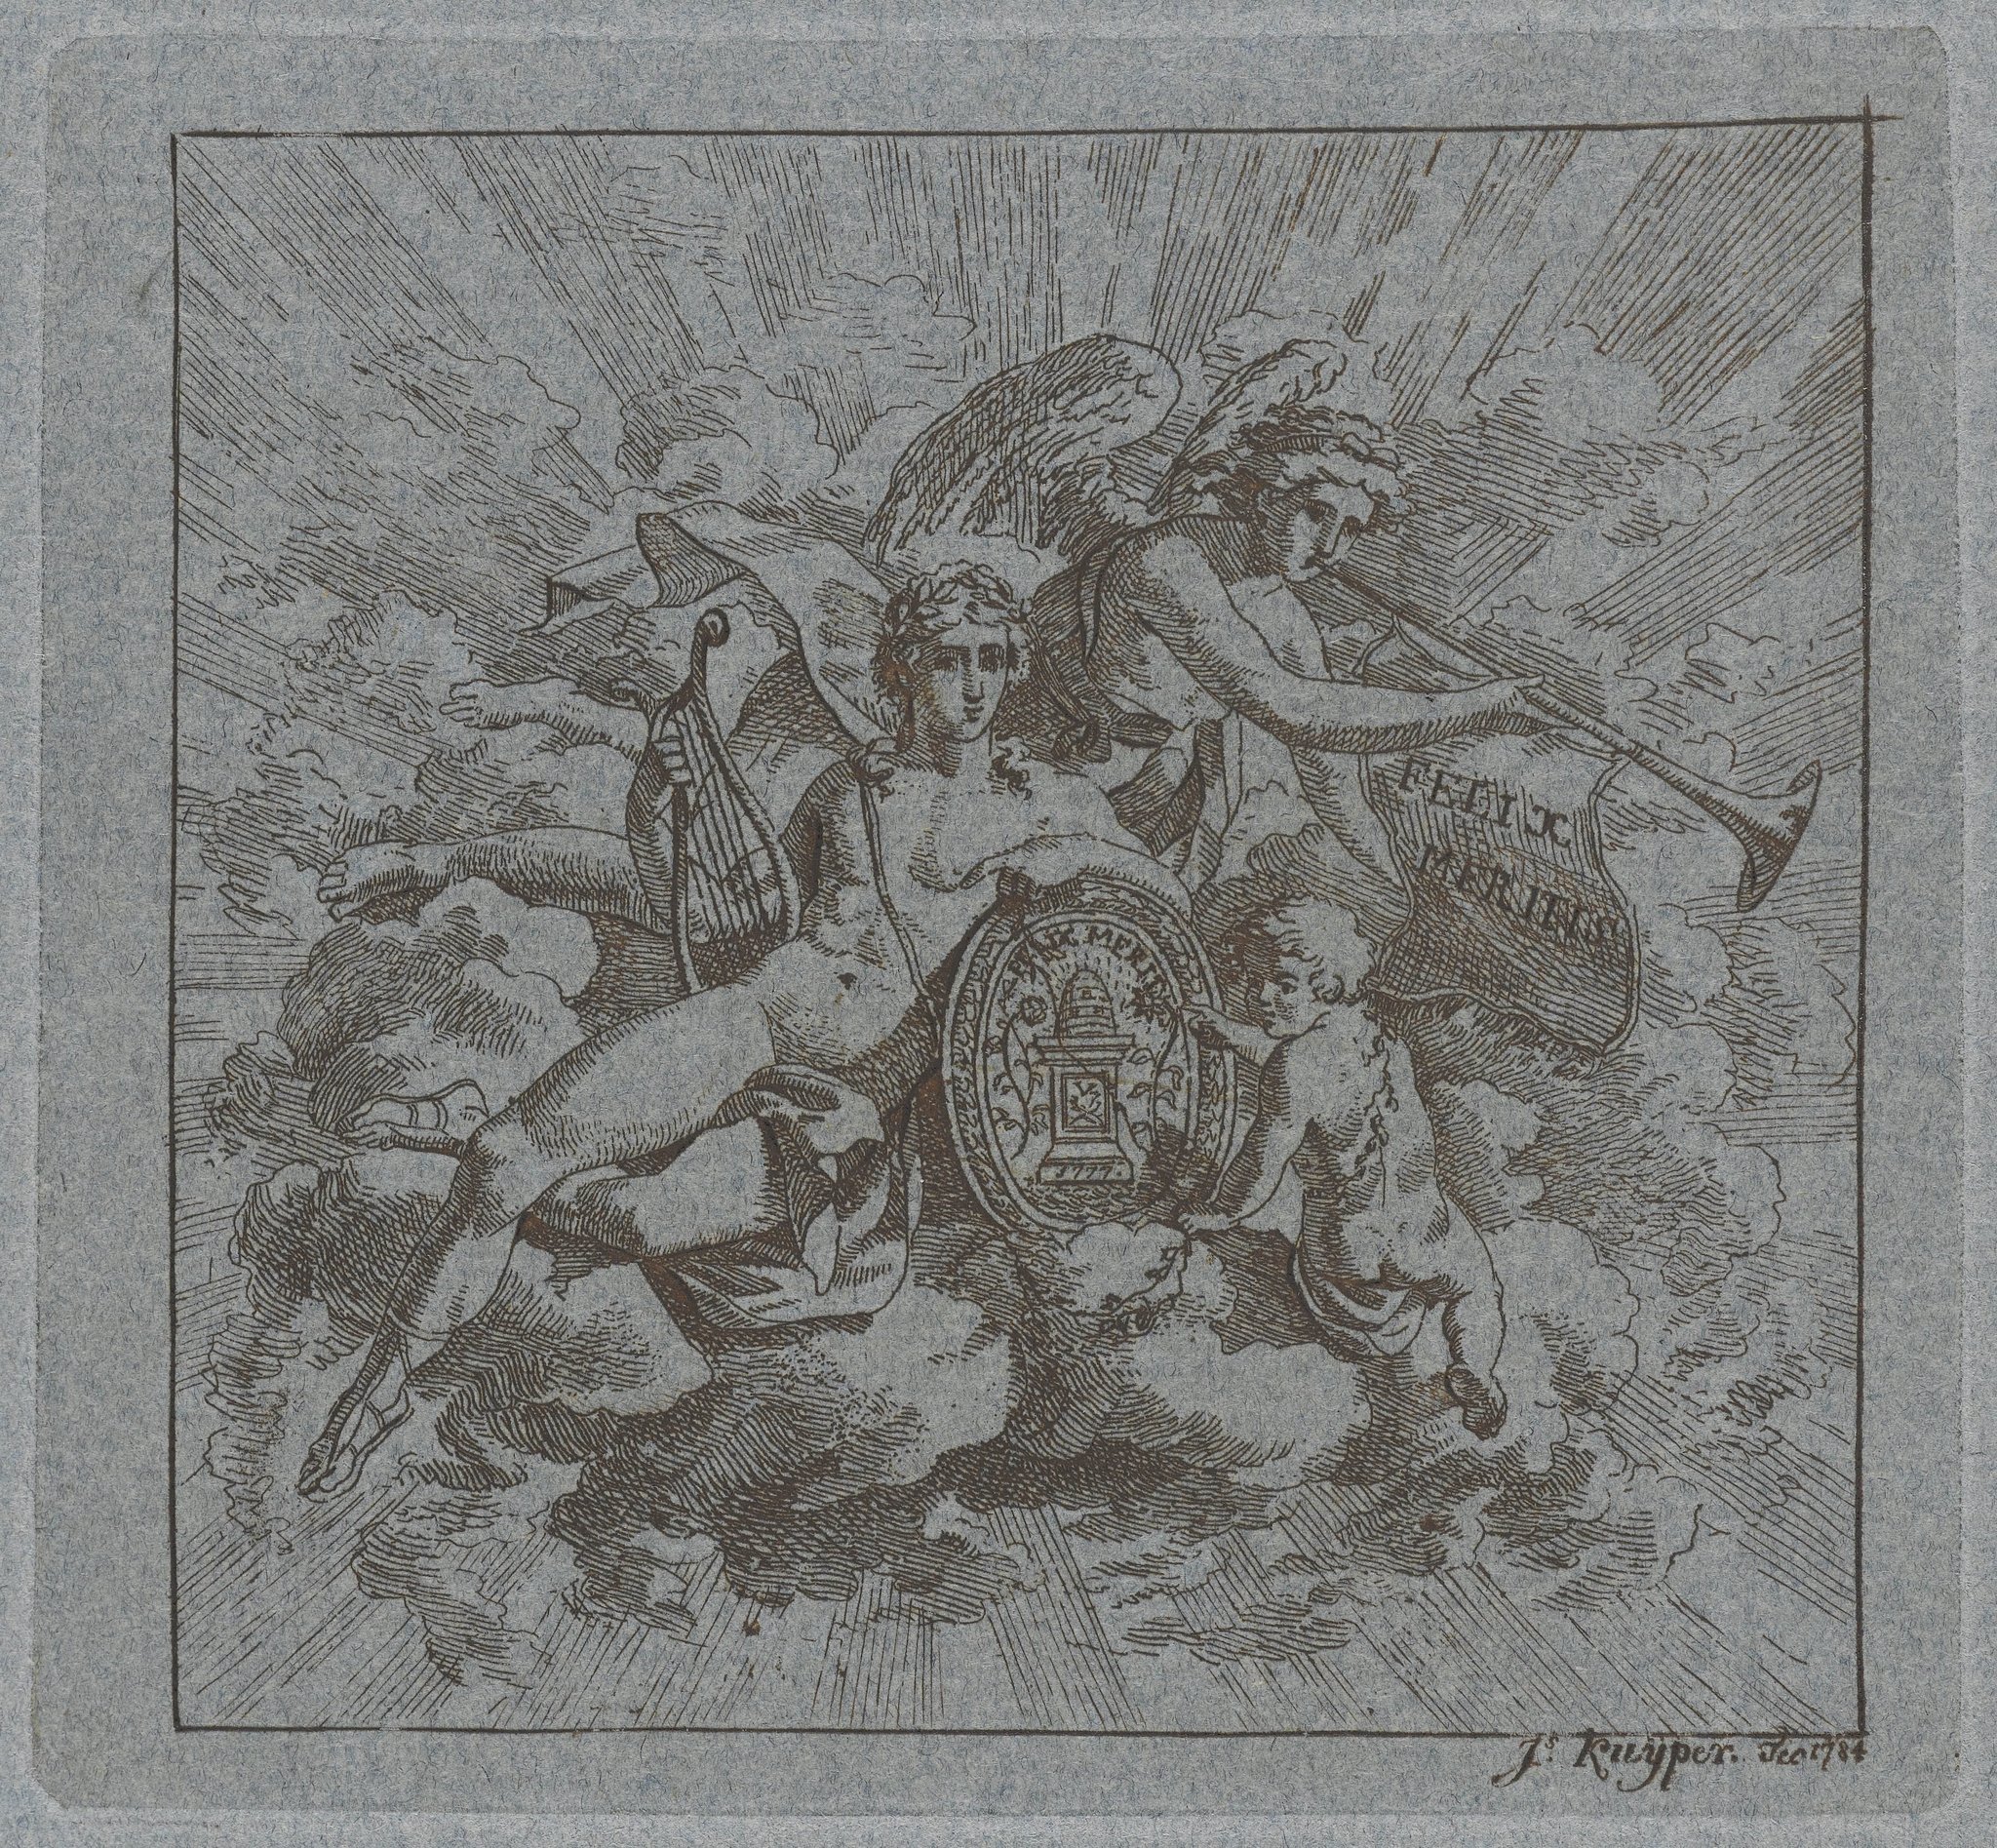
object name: print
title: Allegorische compositie op Felix Meritis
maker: jacques kuyper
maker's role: draughtsman, print maker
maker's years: 1761-1808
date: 1784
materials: paper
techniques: etching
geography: amsterdam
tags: (story of) apollo (phoebus), bee-hive, fame; 'fama', 'fama buona', 'fama chiara' (ripa), cupids: 'amores', 'amoretti', 'putti', amsterdam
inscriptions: collector's mark: Lugt 2228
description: Allegorische compositie op Felix Meritis met rechts de gevleugelde Faam die op de loftrompet blaast. Links rust Apollo, op de wolken gezeten, met de linkerarm op het blasoen van Felix Meritis dat ook door een putto wordt vastgehouden.